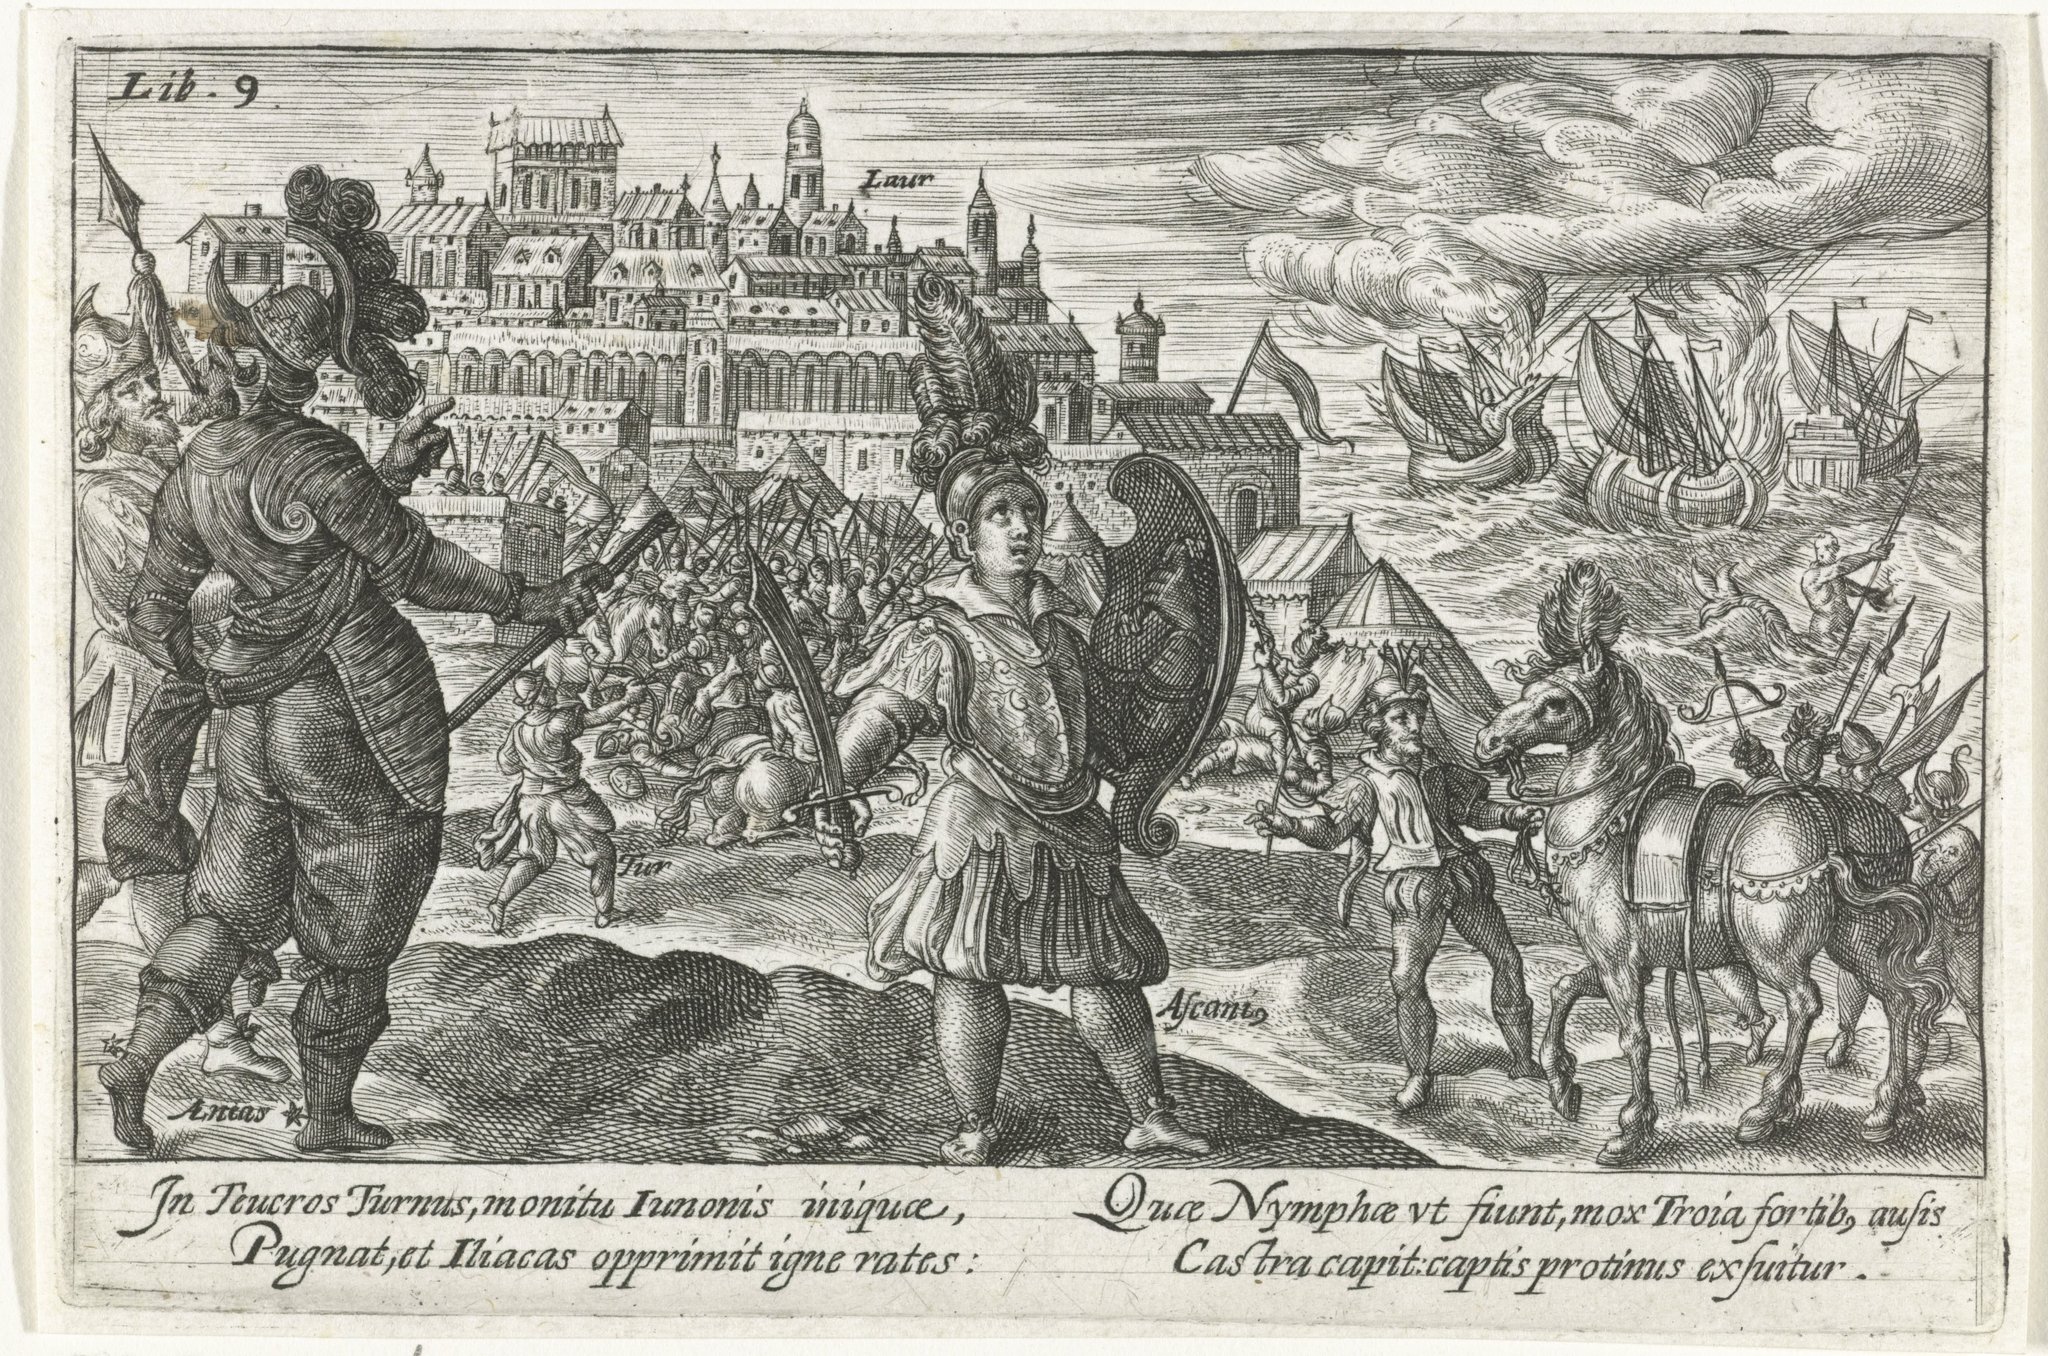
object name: print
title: Speculum Aeneidis Virgilianae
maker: crispijn van de passe (i)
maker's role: draughtsman, print maker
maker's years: 1564-1637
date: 1612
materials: paper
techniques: engraving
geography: utrecht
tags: the siege of the trojan camp ~ battle of latium (virgil, aeneid ix)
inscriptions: collector's mark: Lugt 2228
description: Ascanius, de zoon van Aeneas, vecht voor het Trojaanse kamp, dat wordt belegert door Turnus. Rechts op de achtergrond de Trojaanse schepen die door Turnus in brand zijn gezet. In de marge een vierregelig onderschrift, in twee kolommen, in het Latijn.